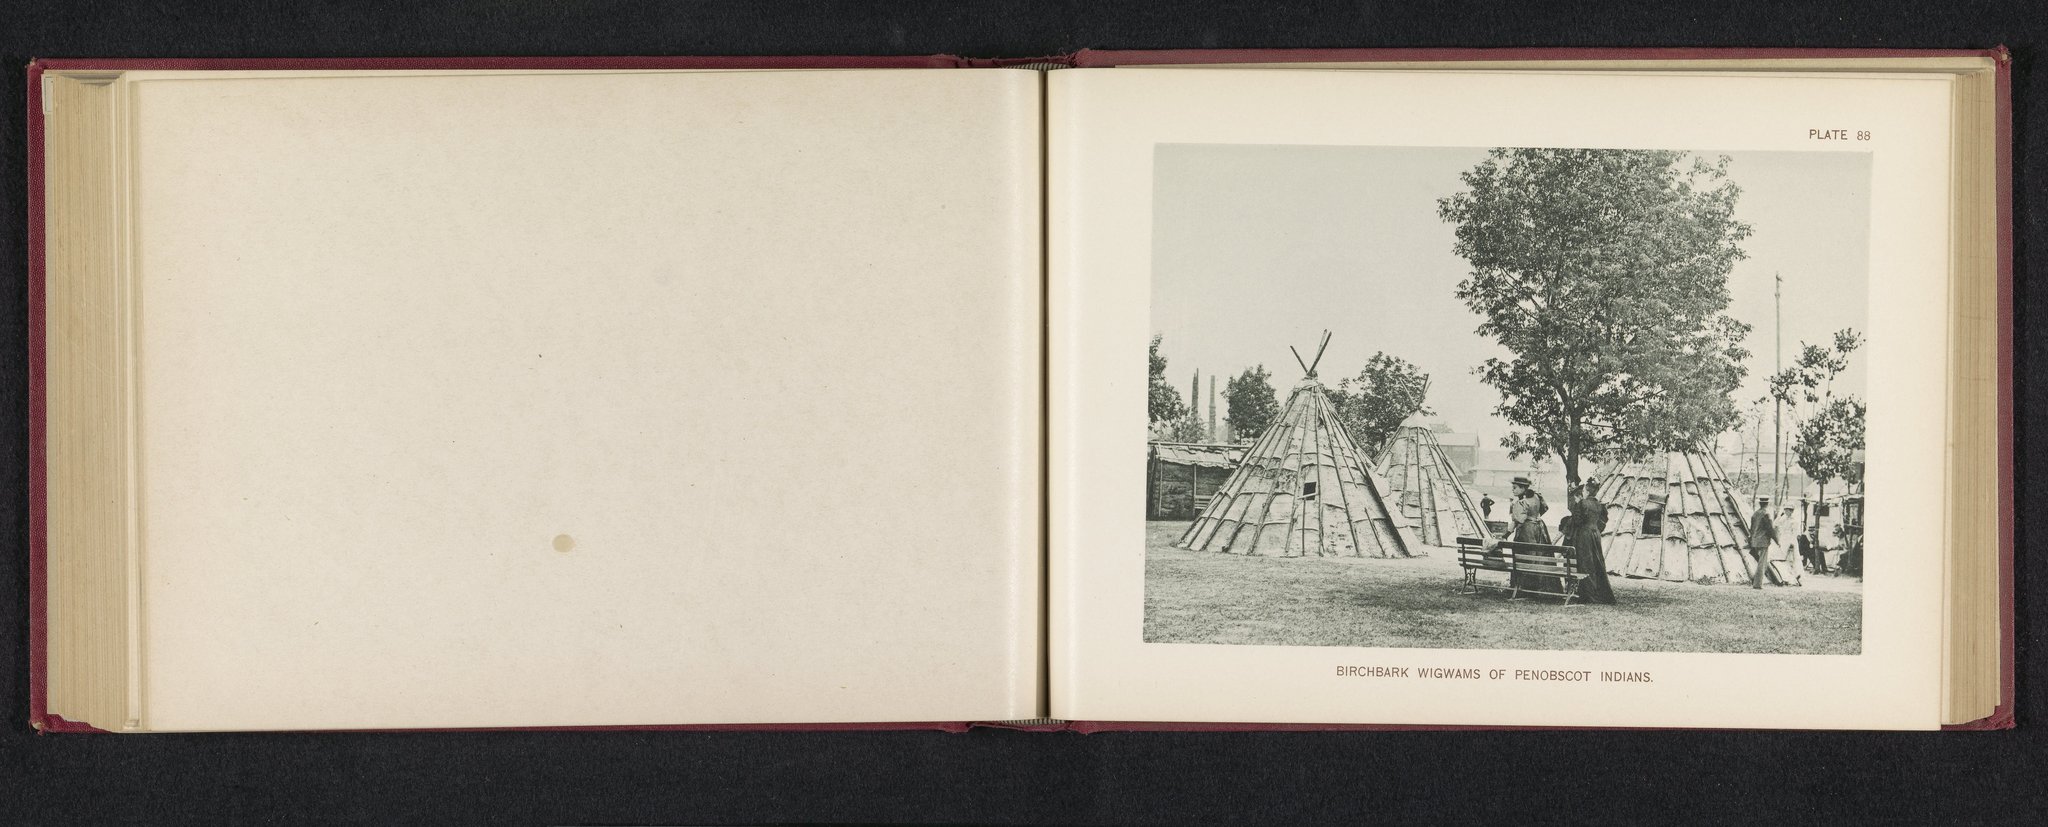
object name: photomechanical print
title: Wigwams van de Penobscot op de World's Columbian Exposition in Chicago in 1893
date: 1893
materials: paper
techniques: photograph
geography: chicago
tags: world fair, world exhibition, wigwam, indigenous peoples of north america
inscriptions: number: ‘Plate 88’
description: Tipi’s van de Panawahpskek (Penobscot) op de World’s Columbian Exposition in Chicago in 1893. De wigwams zijn bedekt met berkenbast.